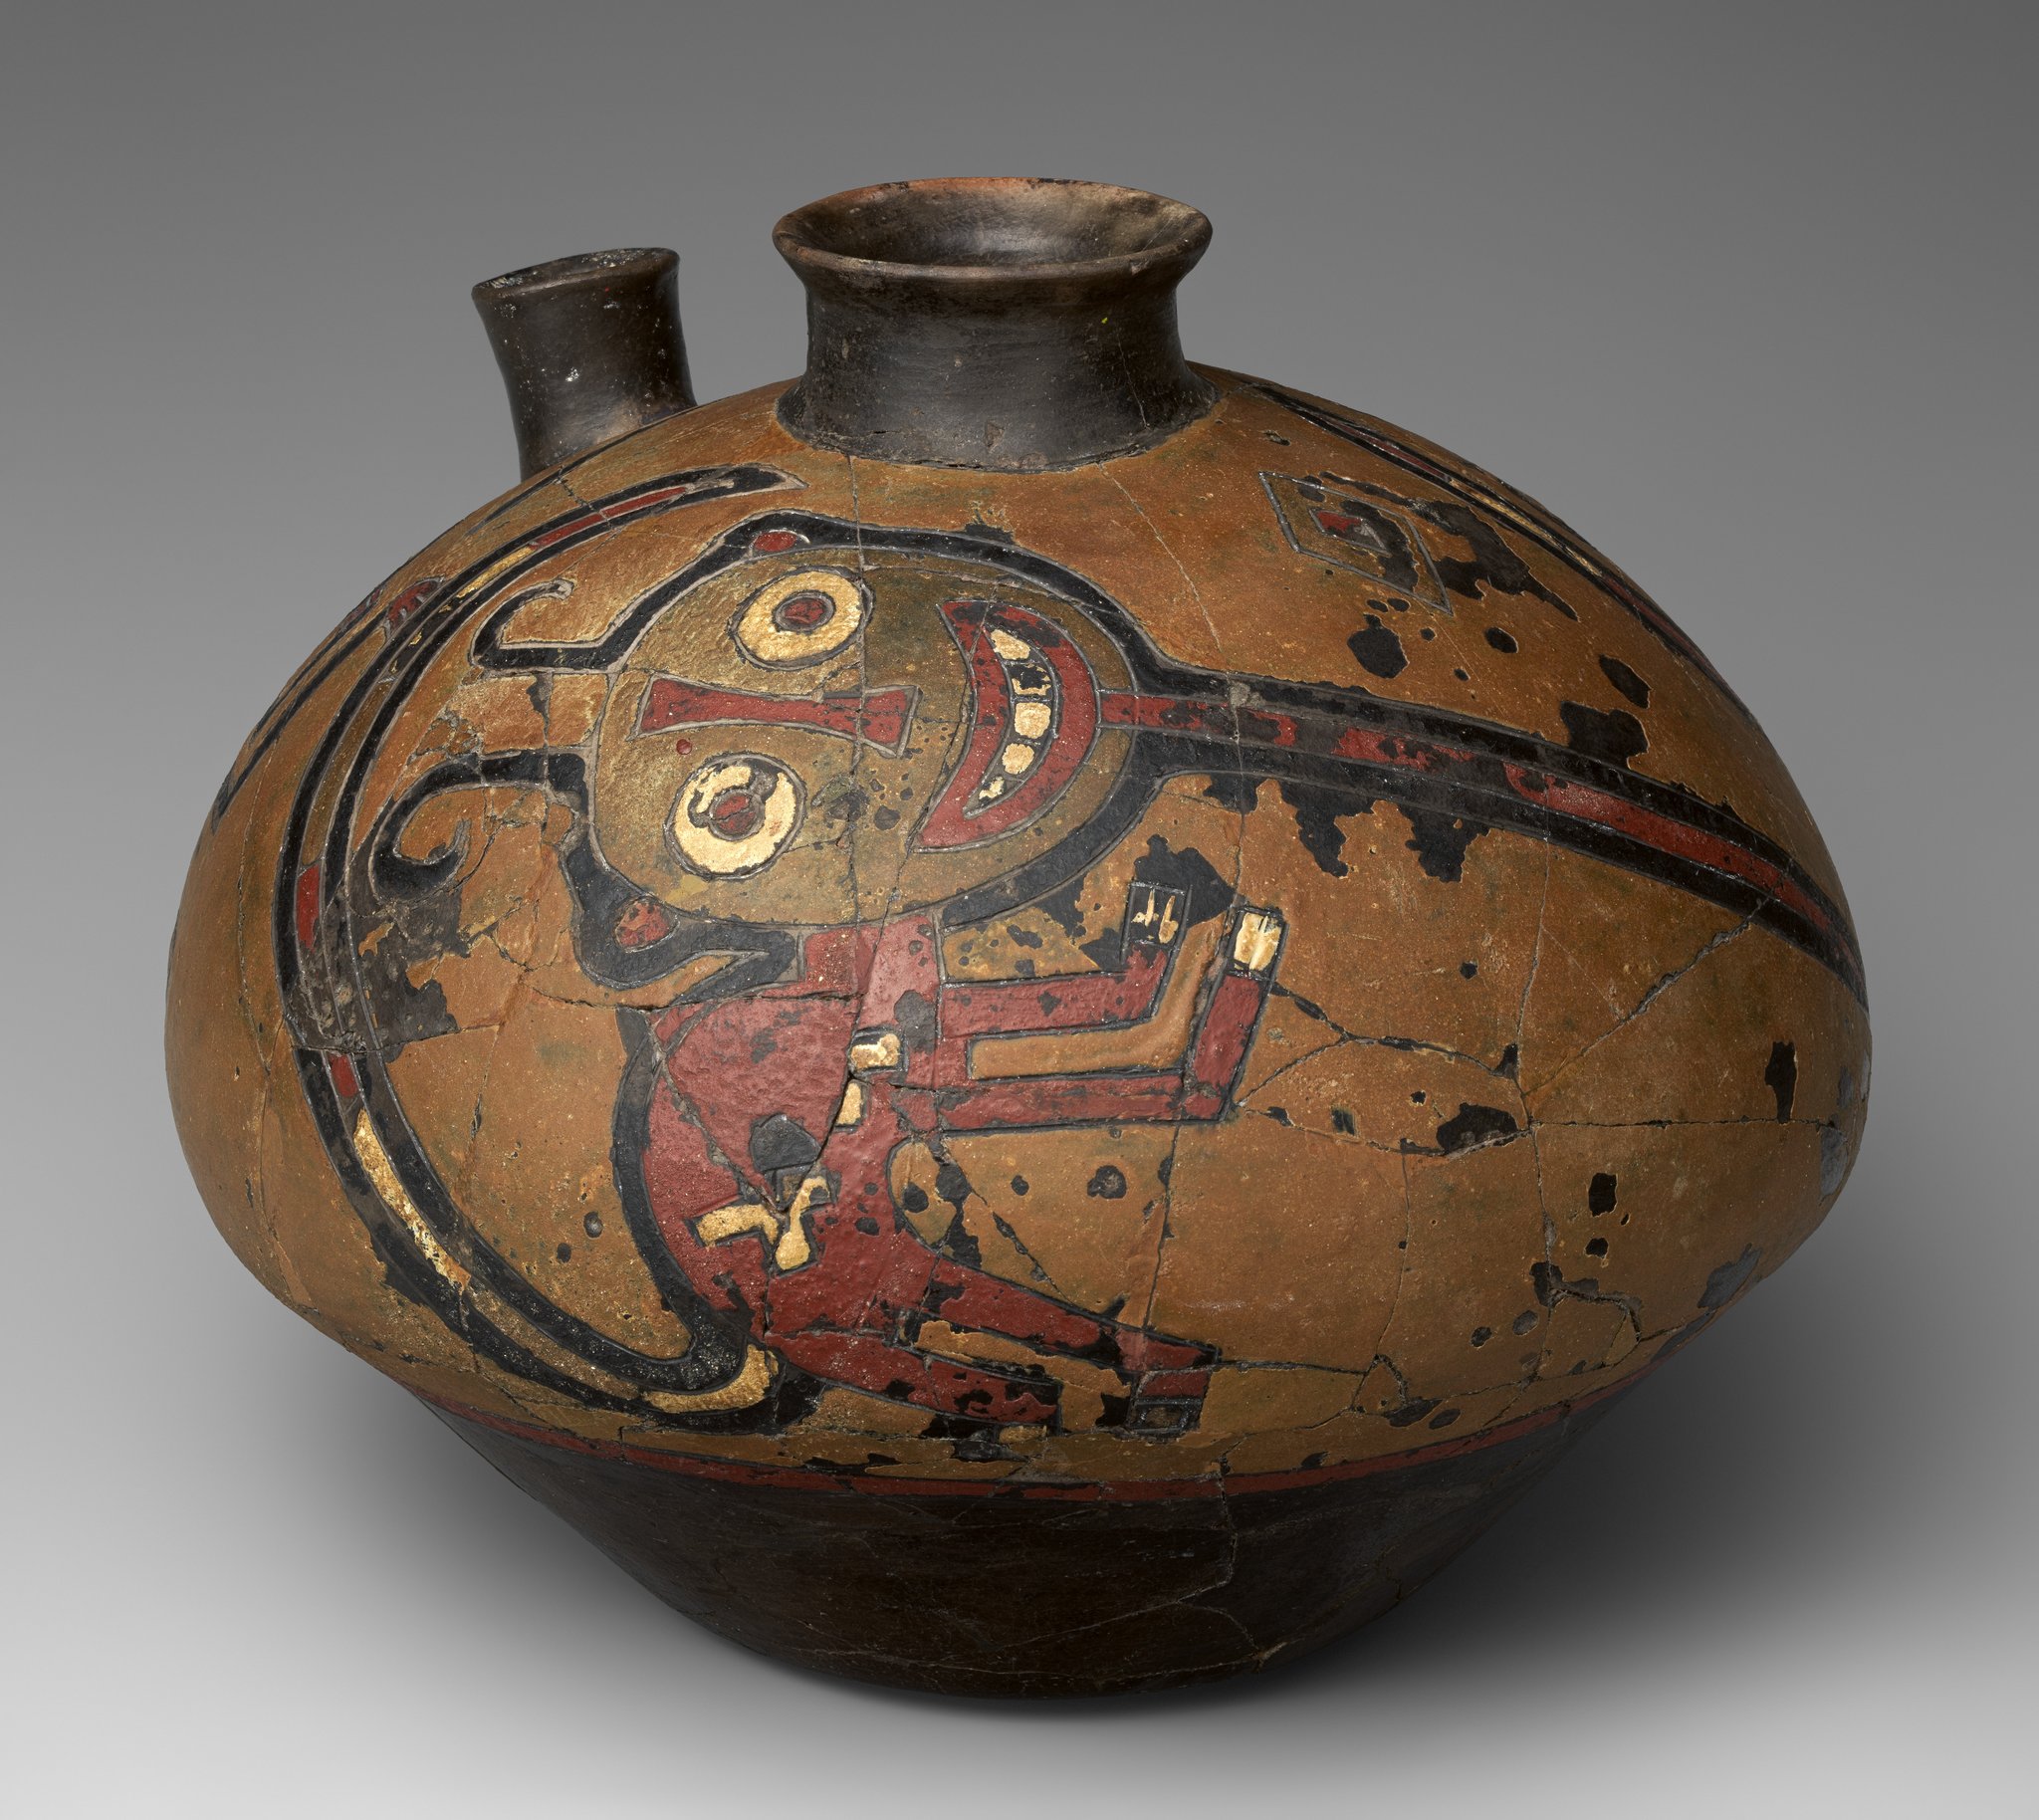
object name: bottle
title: Jar with flying figure (the Oculate Being)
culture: paracas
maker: paracas artist(s)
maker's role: artist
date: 350 BCE-60 CE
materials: ceramic, paint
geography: peru